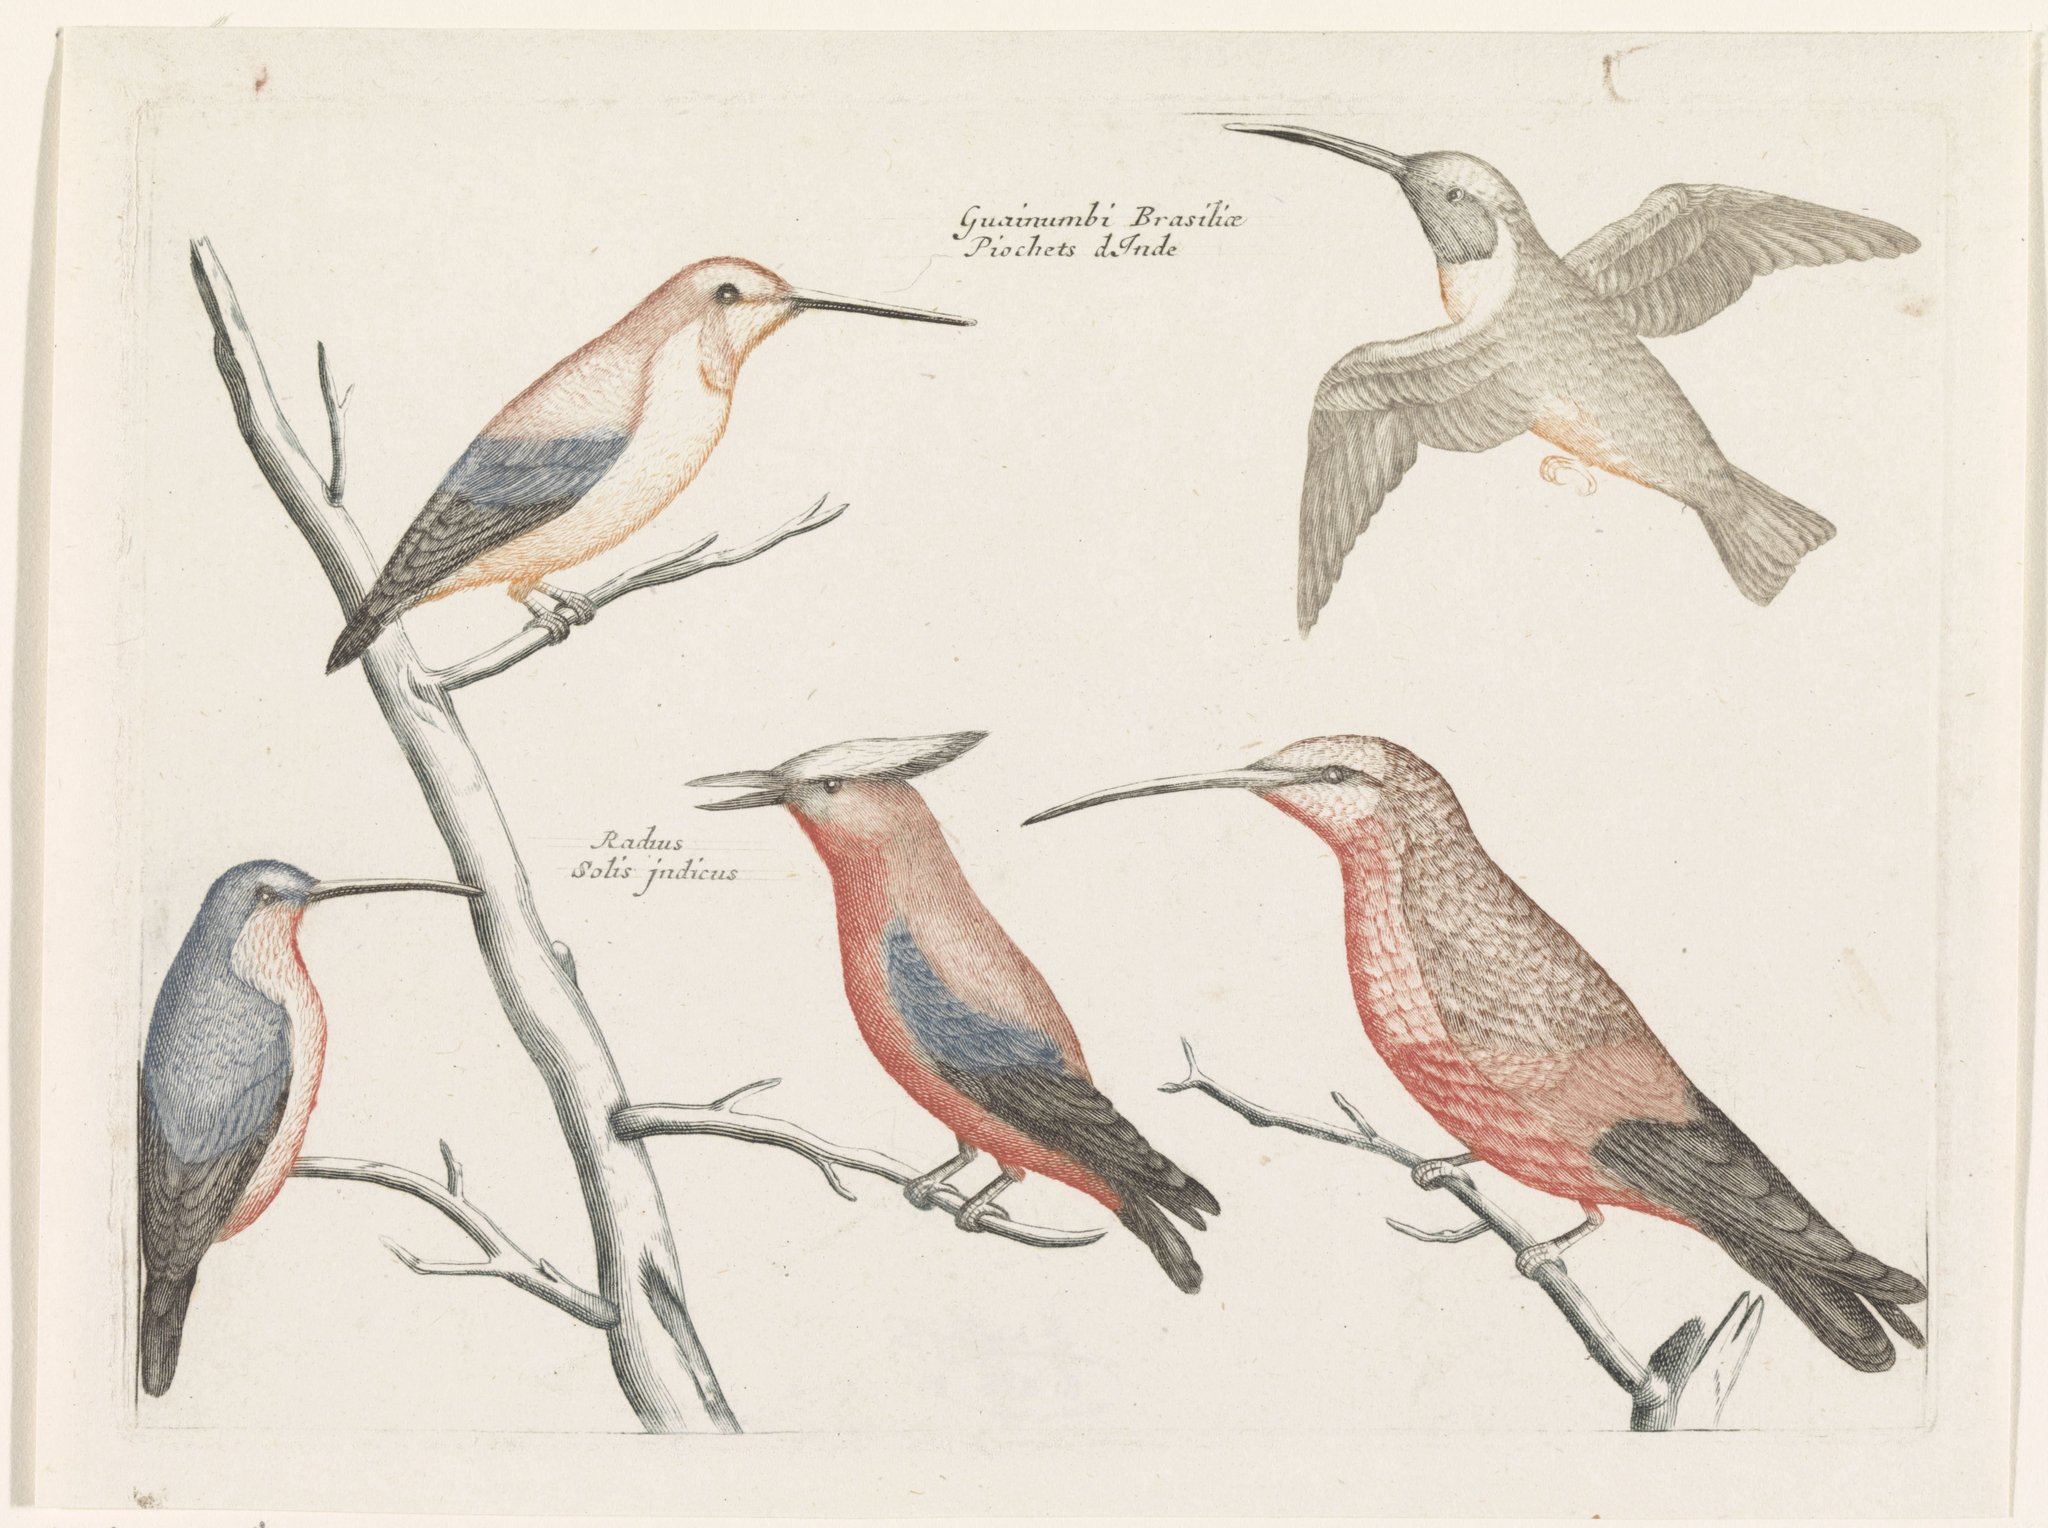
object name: print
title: Vijf verschillende soorten kolibries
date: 1688-1698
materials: paper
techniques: printing, engraving, lithography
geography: netherlands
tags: other birds (with name)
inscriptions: collector's mark: Lugt 2228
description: Vijf verschillende soorten kolibries. Daarnaast de naam in het Latijn en Frans.